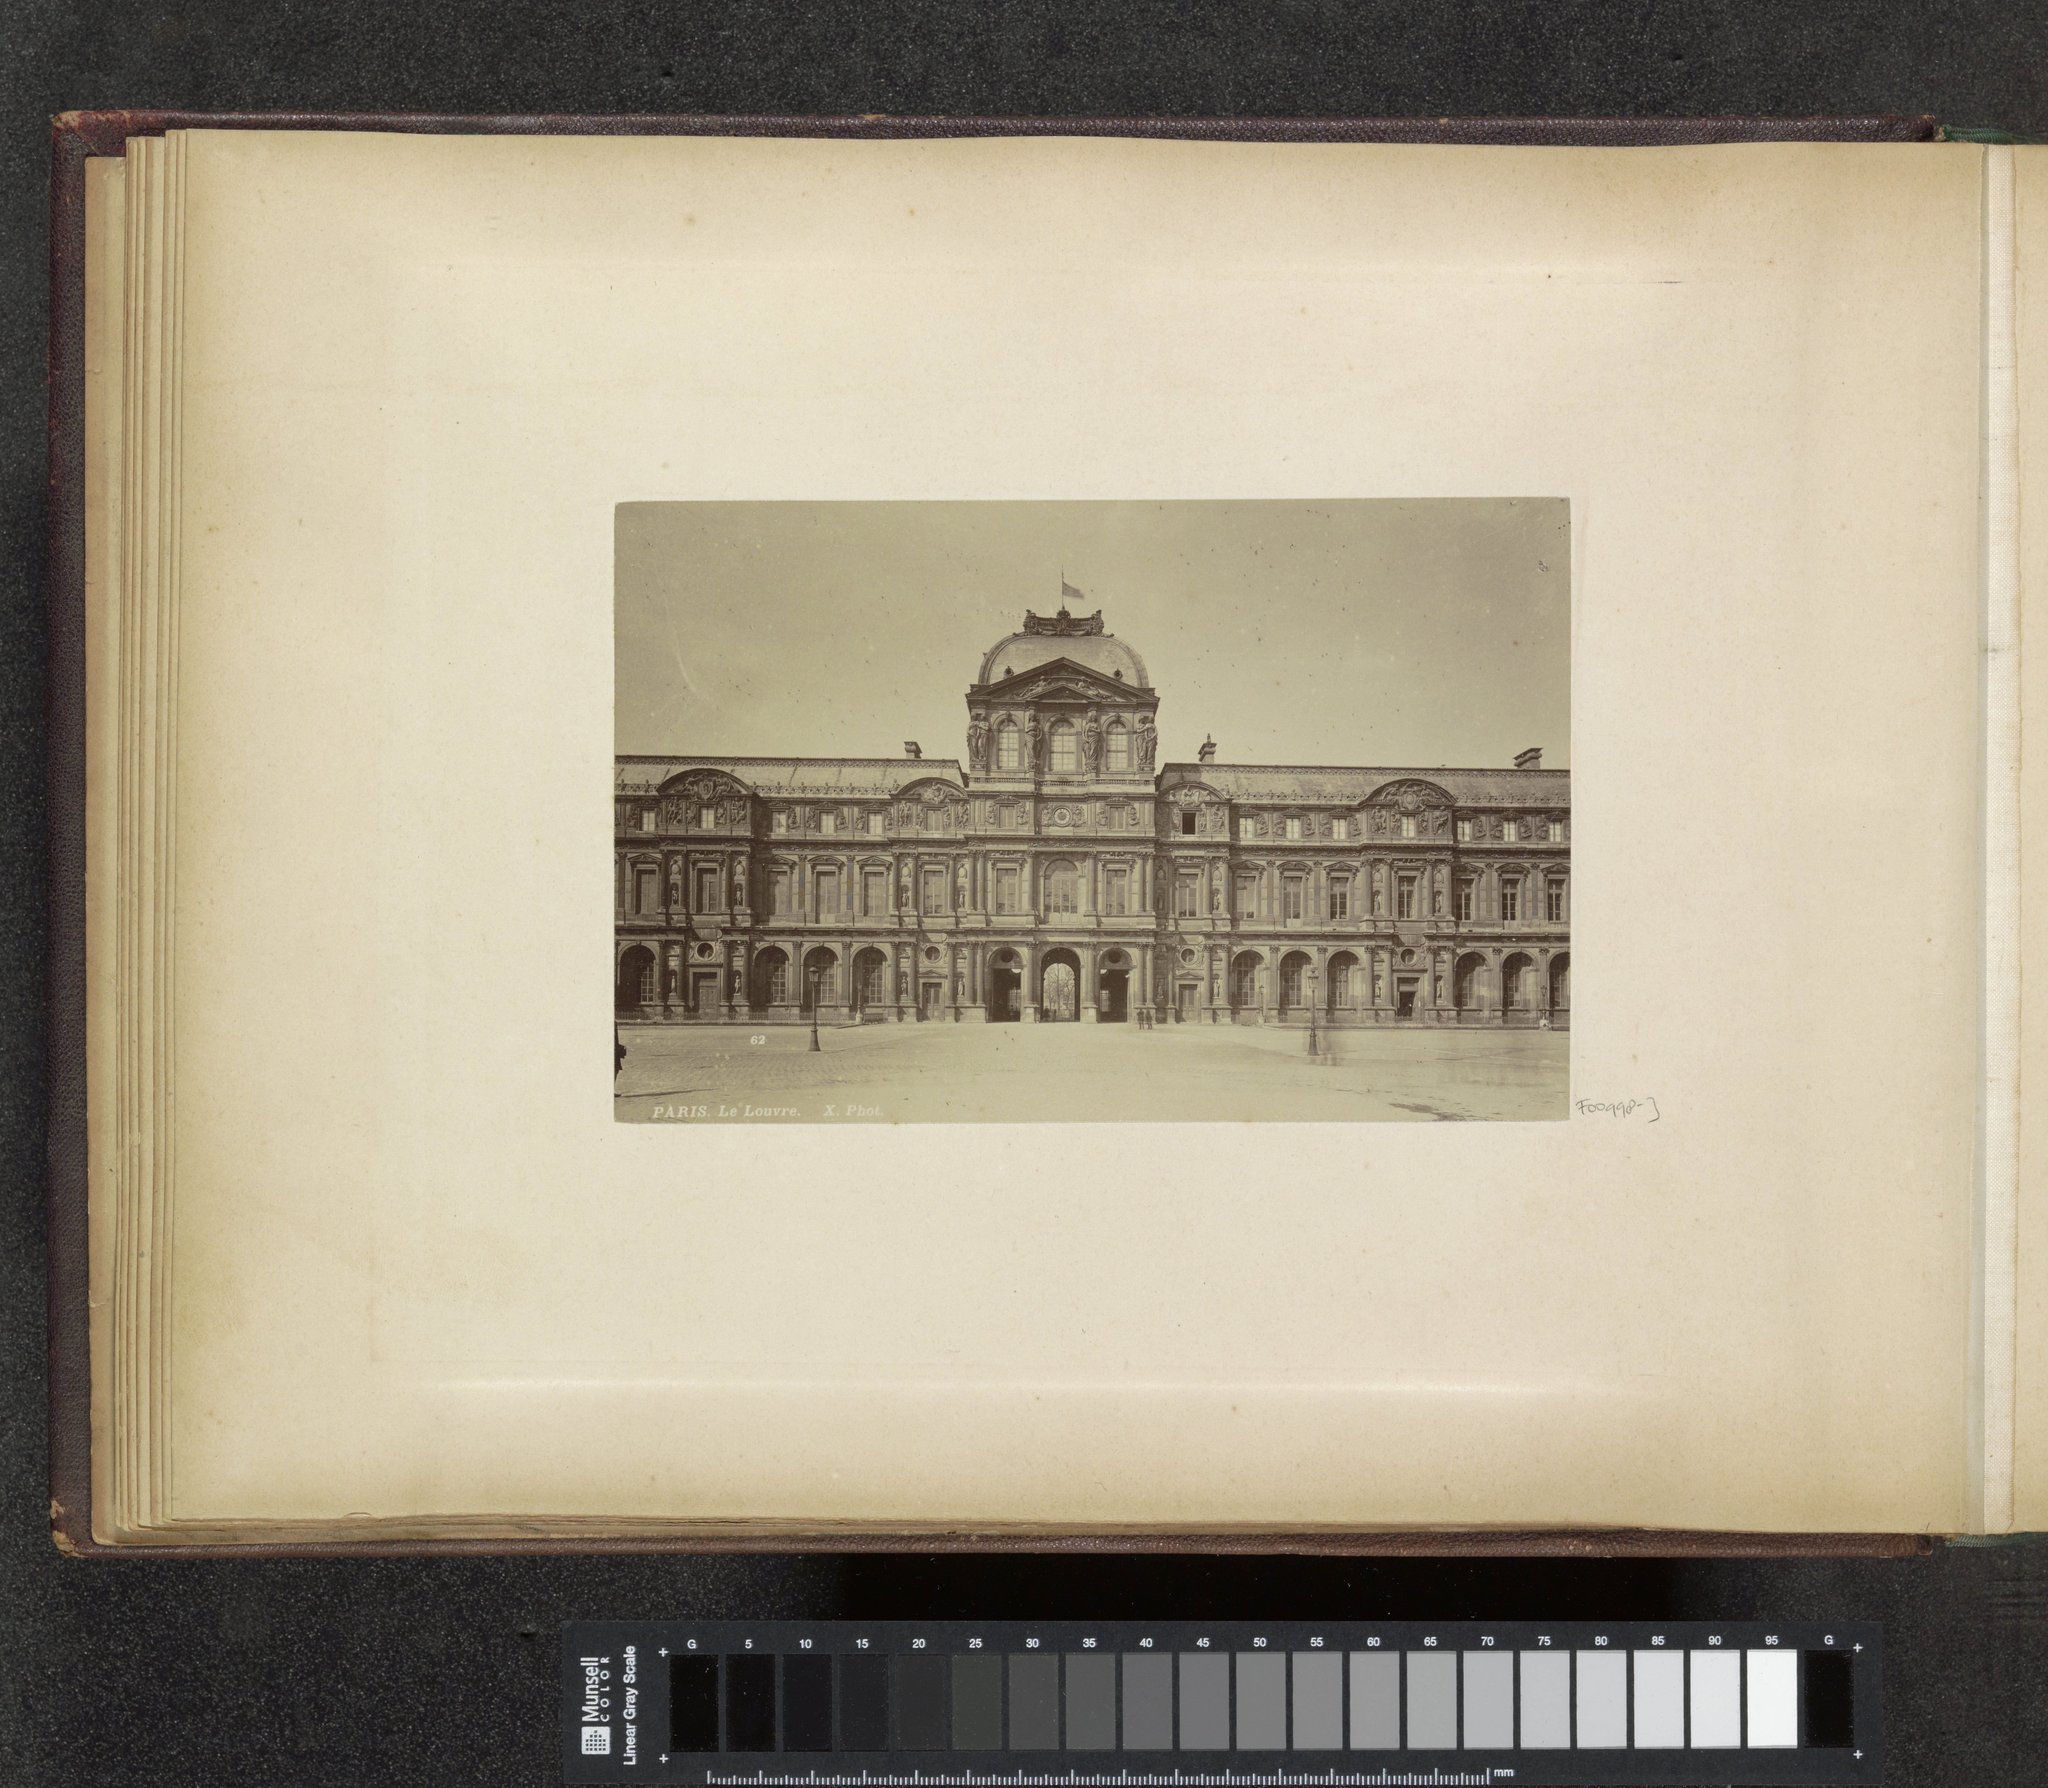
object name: photograph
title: PARIS. Le Louvre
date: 1880-1890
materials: paper, photographic support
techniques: albumen print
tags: permanent exhibition, museum, façade (of house or building)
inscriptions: negative number: ‘62’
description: Onderdeel van Reisalbum met foto's van bezienswaardigheden in Frankrijk, Griekenland en Turkije.